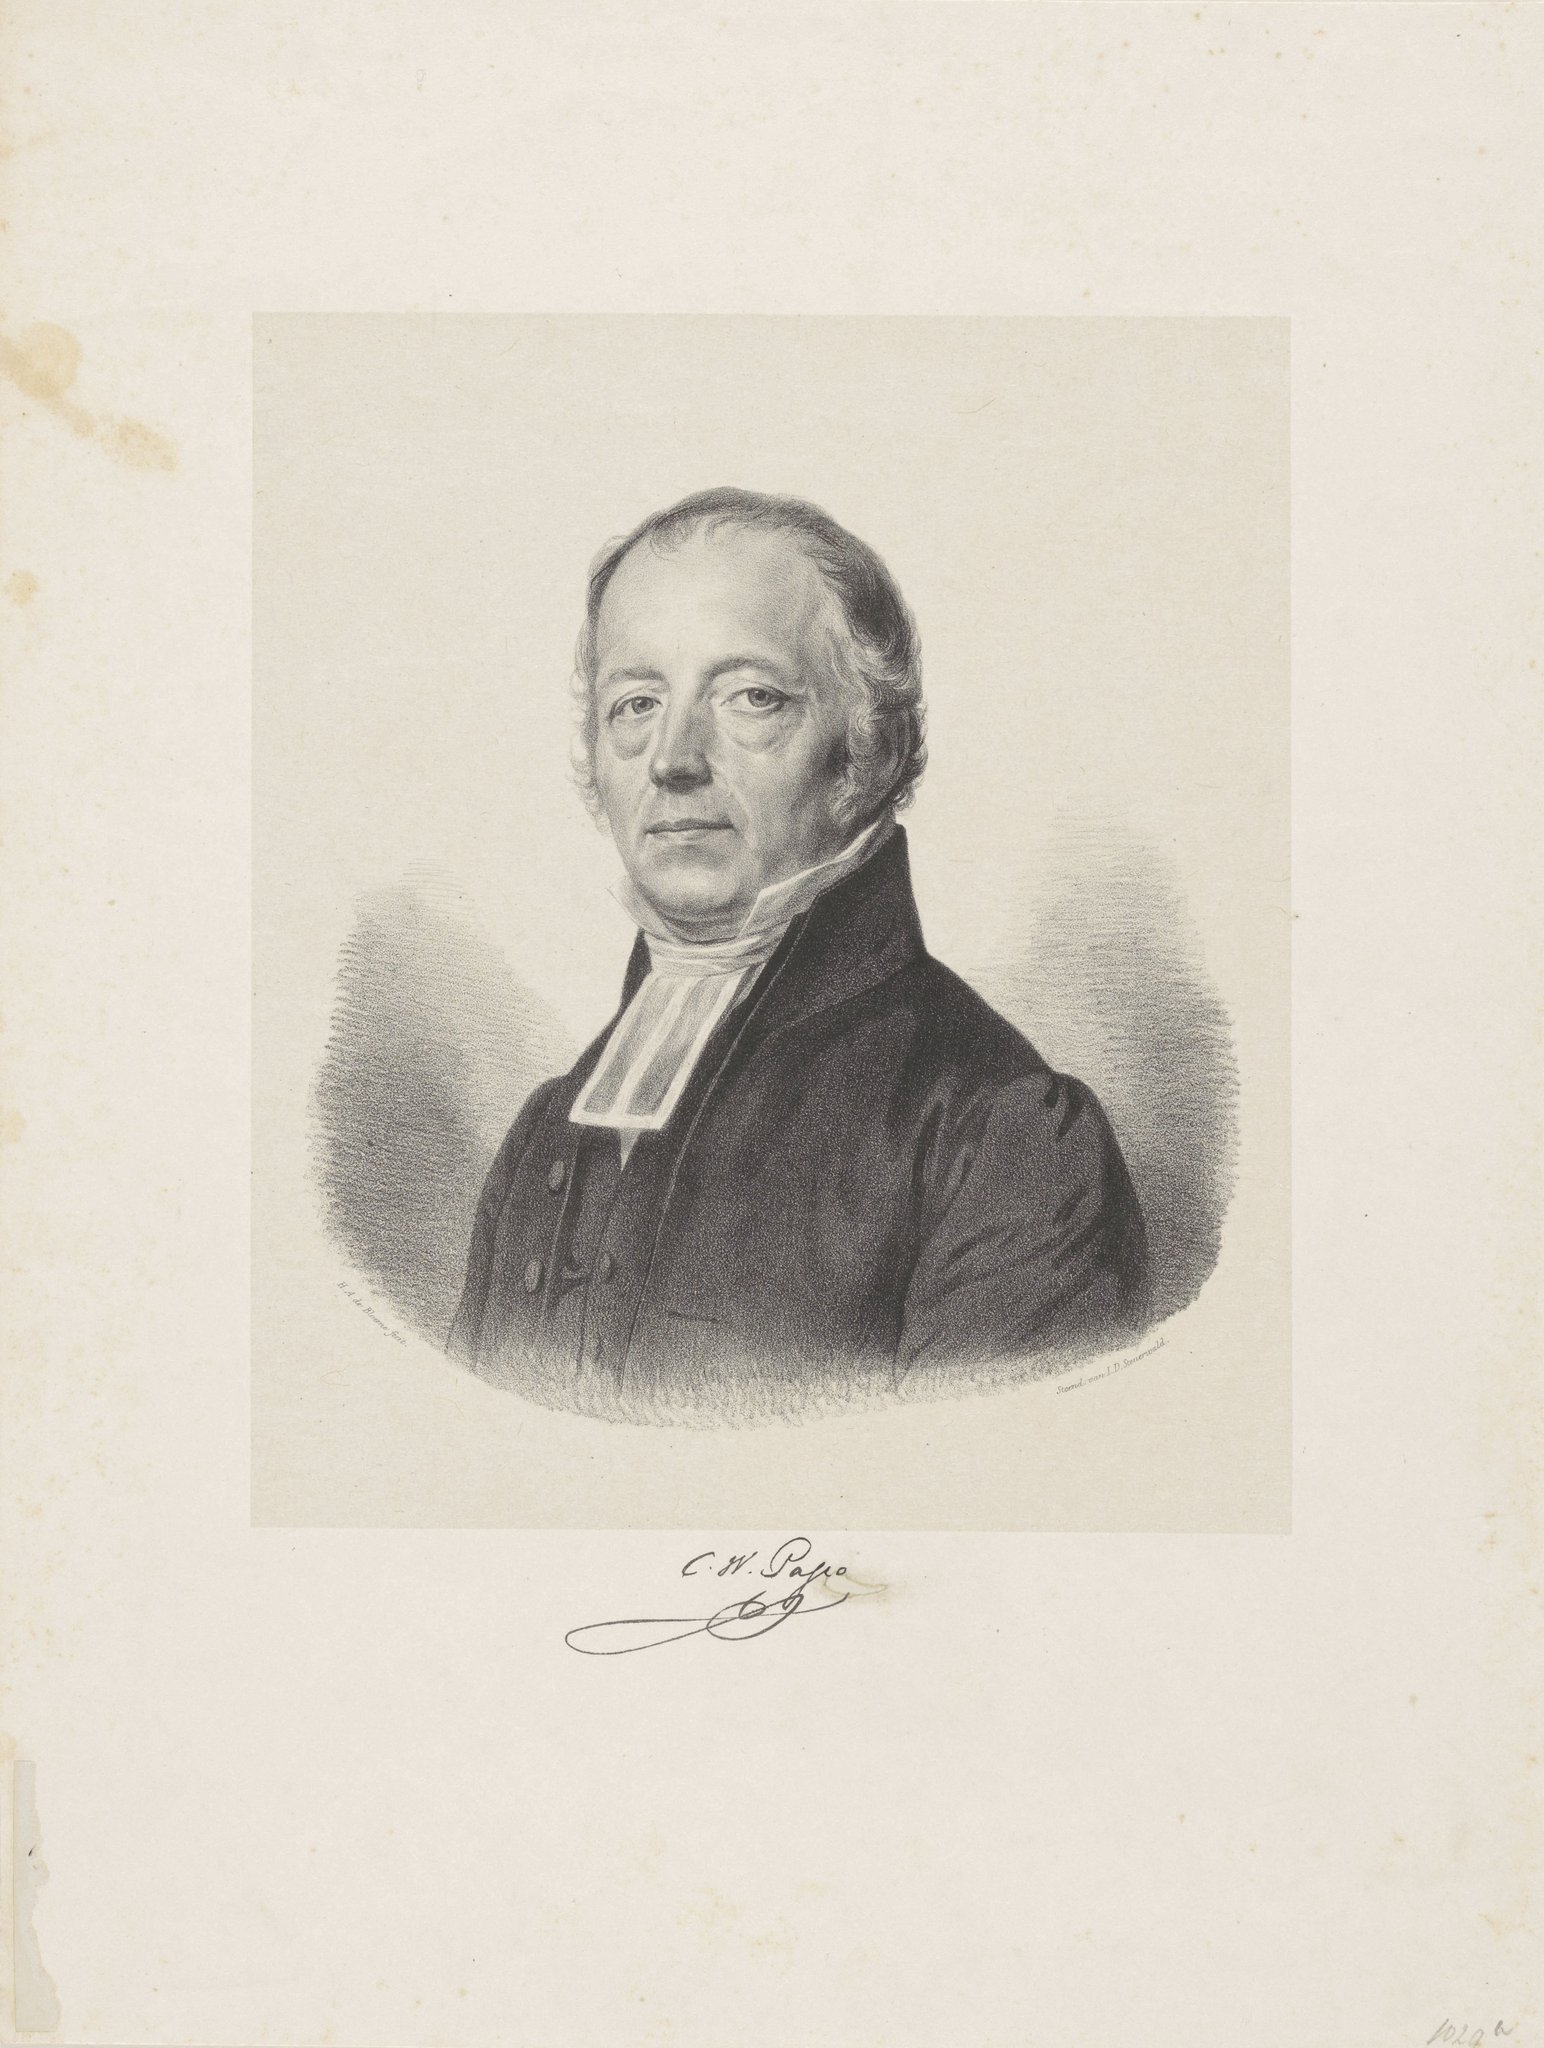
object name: print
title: Portret van Carel Willem Pape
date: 1812-1863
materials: paper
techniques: lithograph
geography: the hague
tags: the hague, historical persons (+ (full) bust portrait)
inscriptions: collector's mark: Lugt 2228, inscription: ‘C. W. Pape’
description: De geportretteerde draagt een donkere jas en een bef.